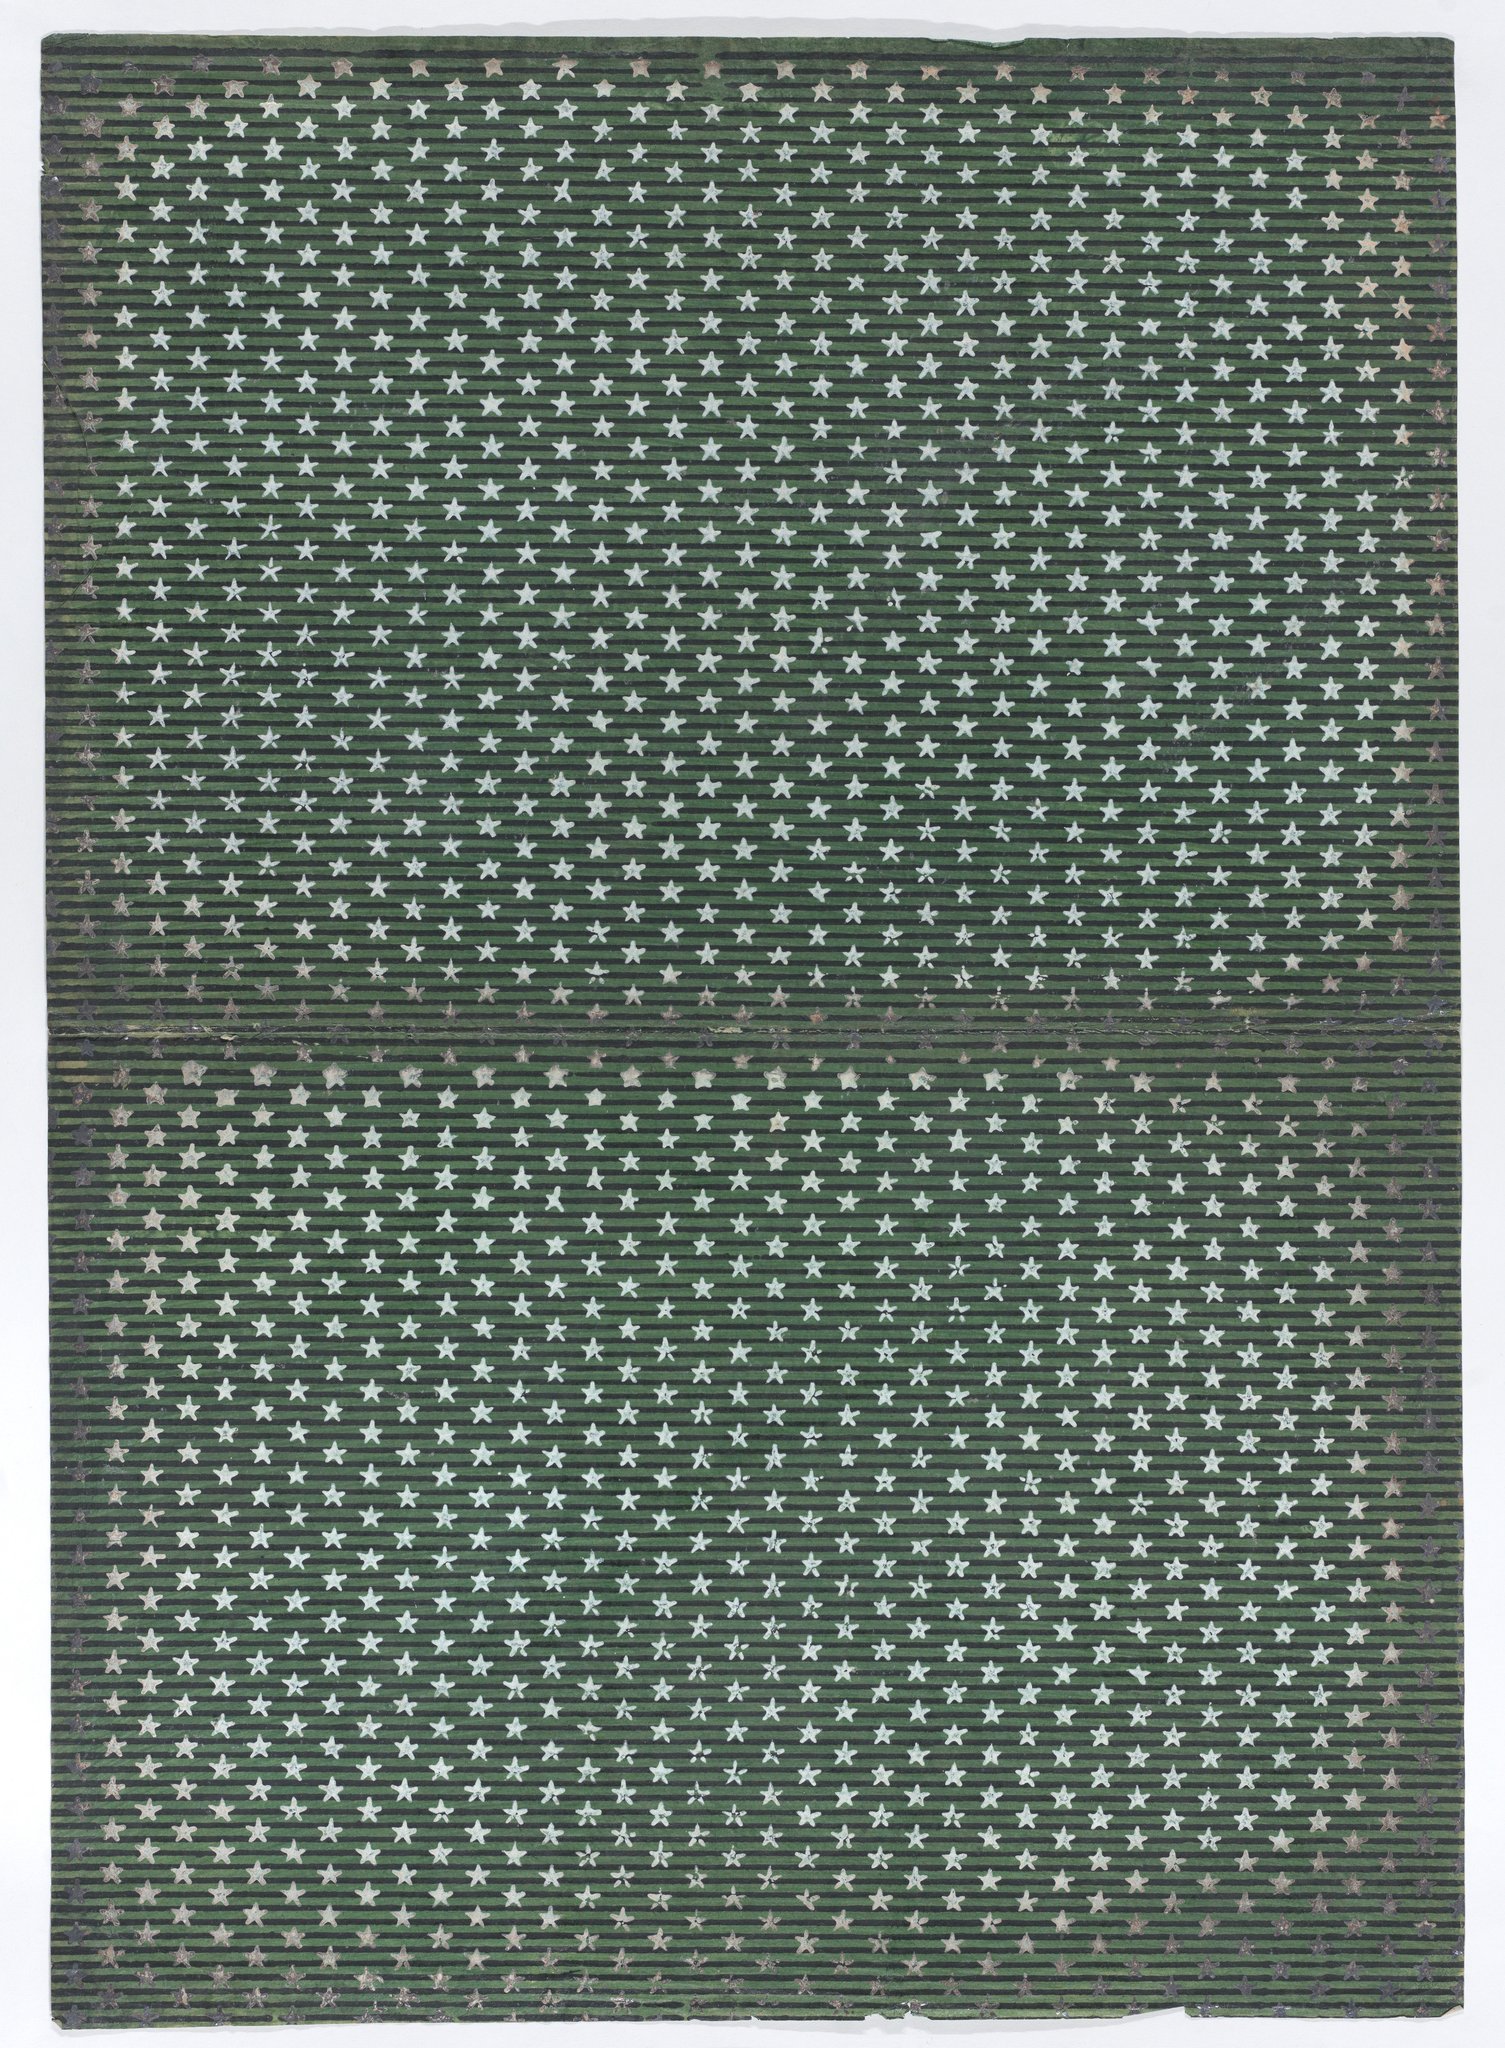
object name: print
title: Book cover with overall pattern of stars and stripes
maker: Anonymous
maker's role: artist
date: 1801-1900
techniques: relief print